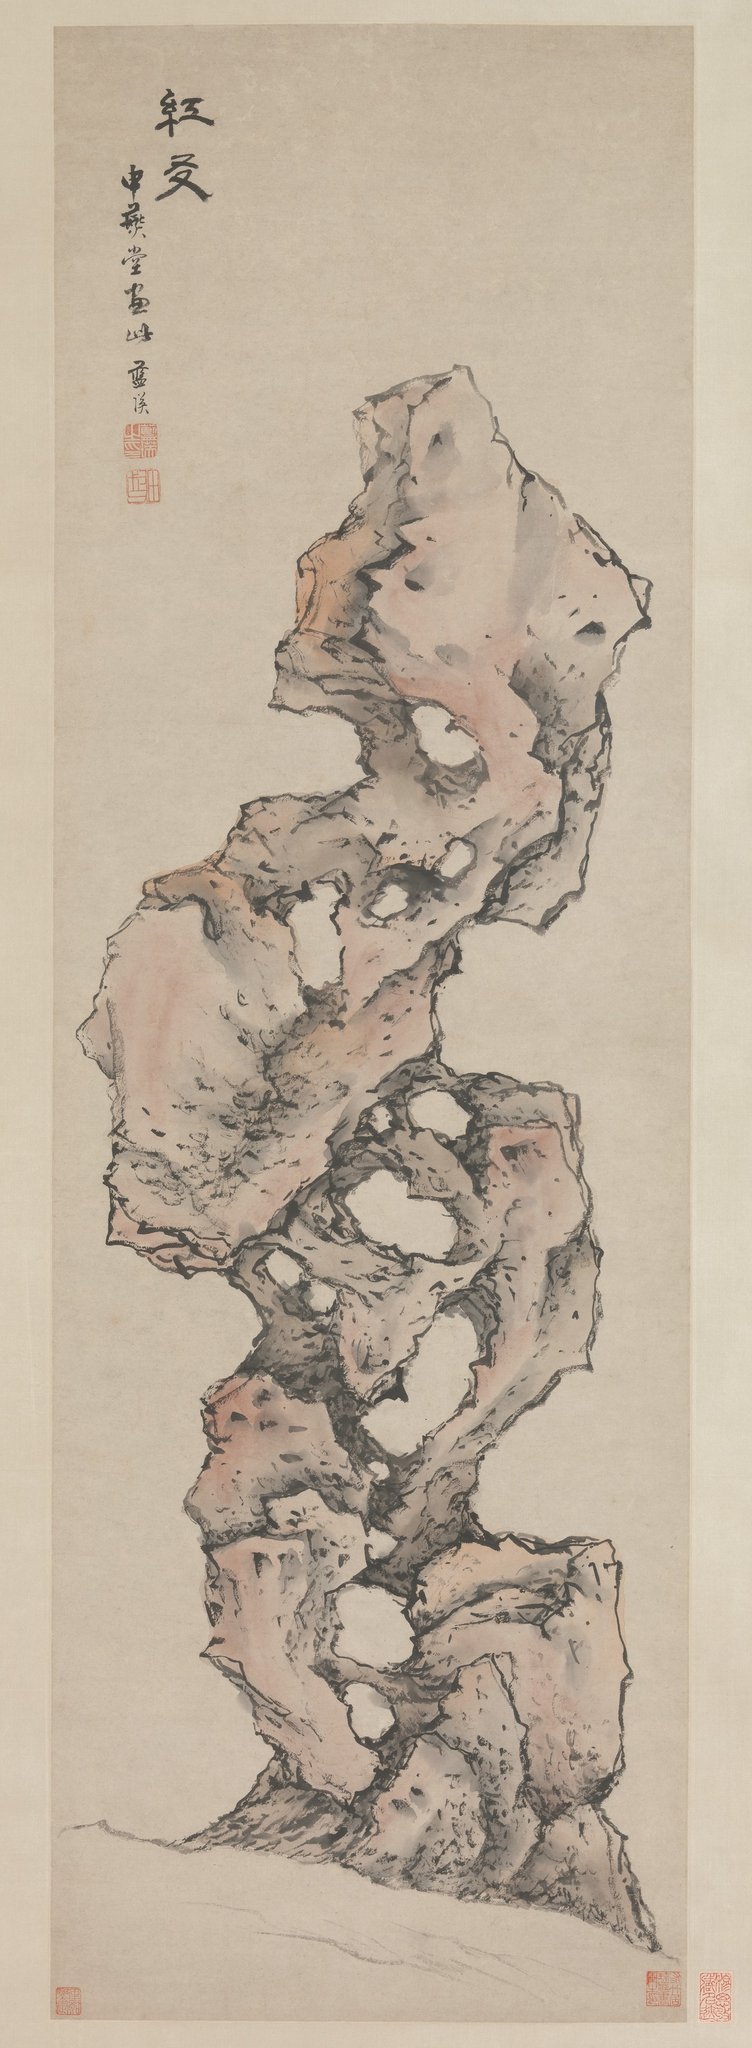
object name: hanging scroll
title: Red Friend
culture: chinese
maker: lan ying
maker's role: artist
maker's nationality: chinese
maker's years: 1585-1664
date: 1601-1700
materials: ink, paper